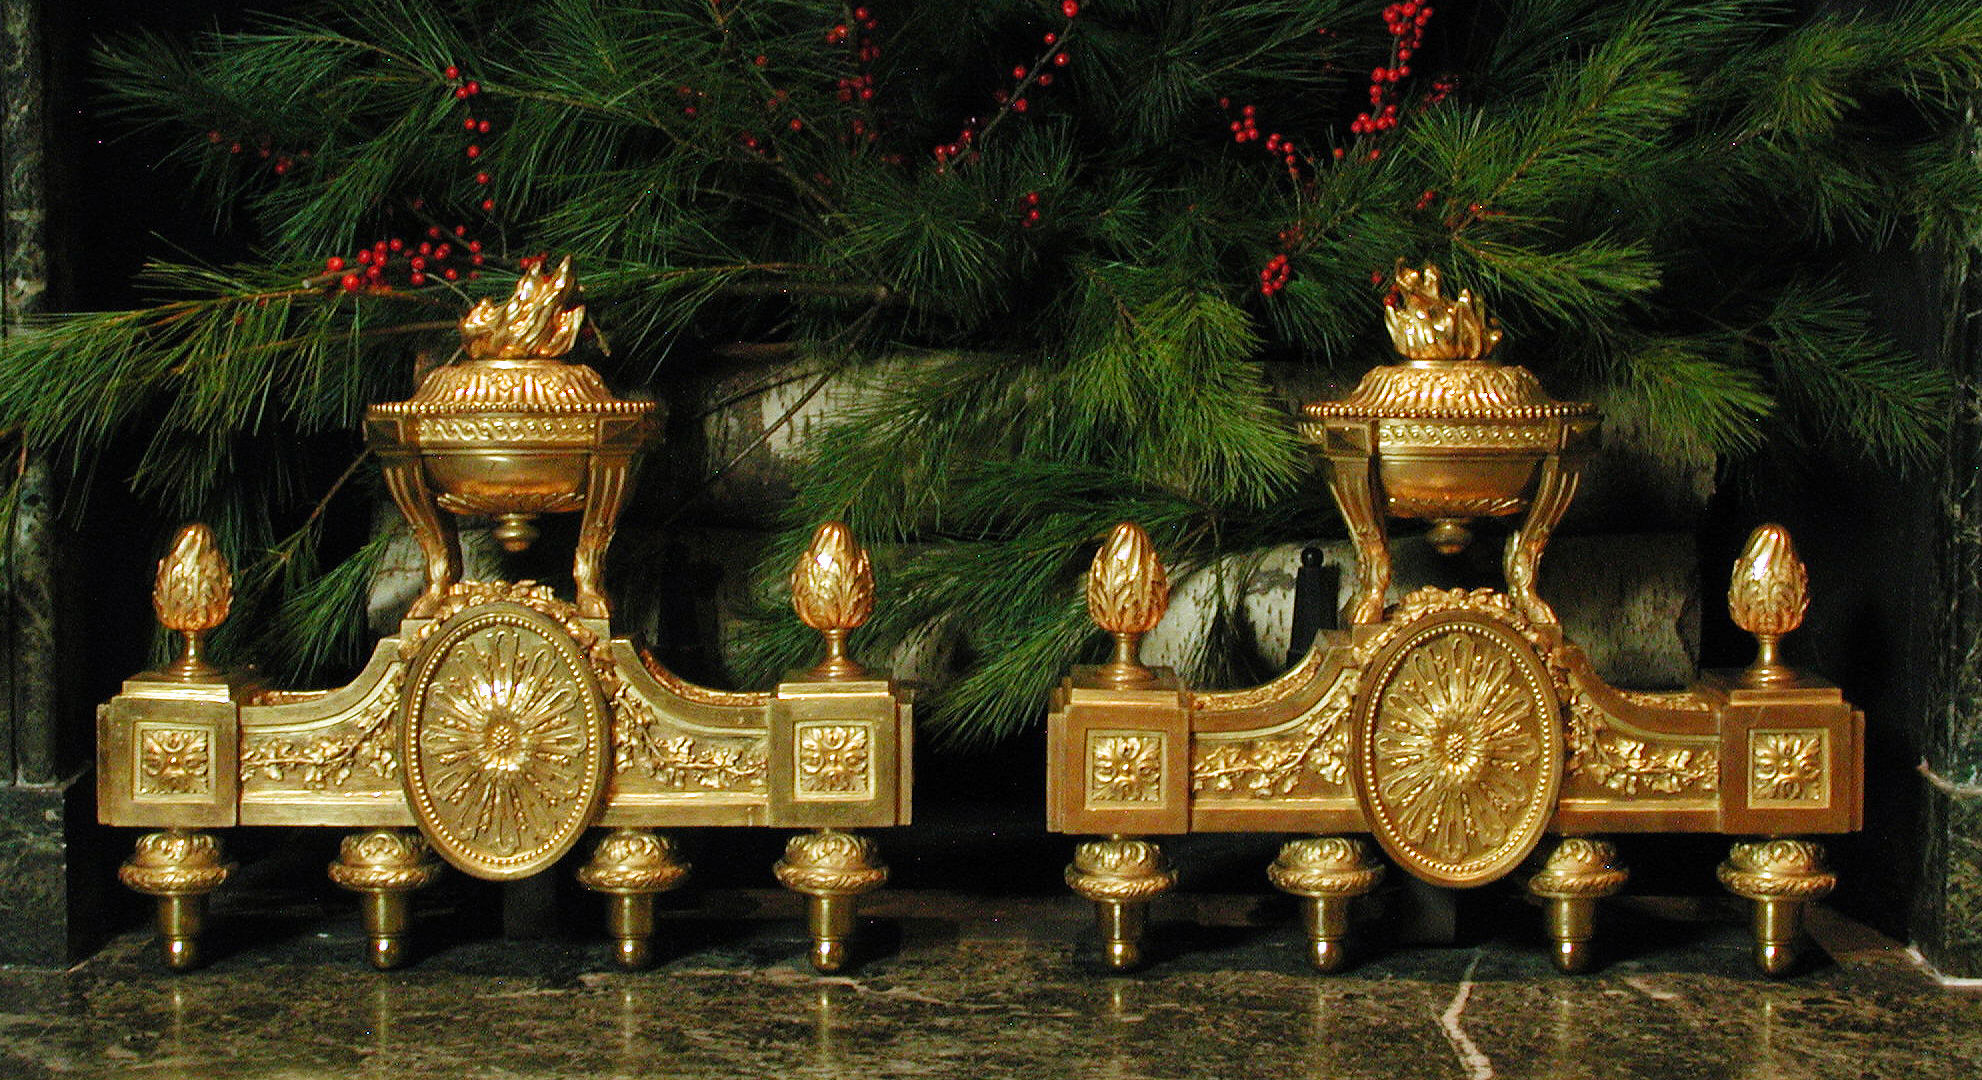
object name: firedog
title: Pair of firedogs (chenets)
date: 1780-1785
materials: gilt bronze